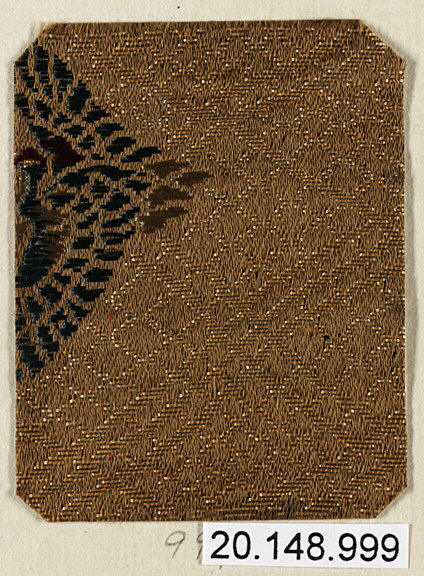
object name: piece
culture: japanese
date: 1701-1800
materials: silk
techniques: compound weave